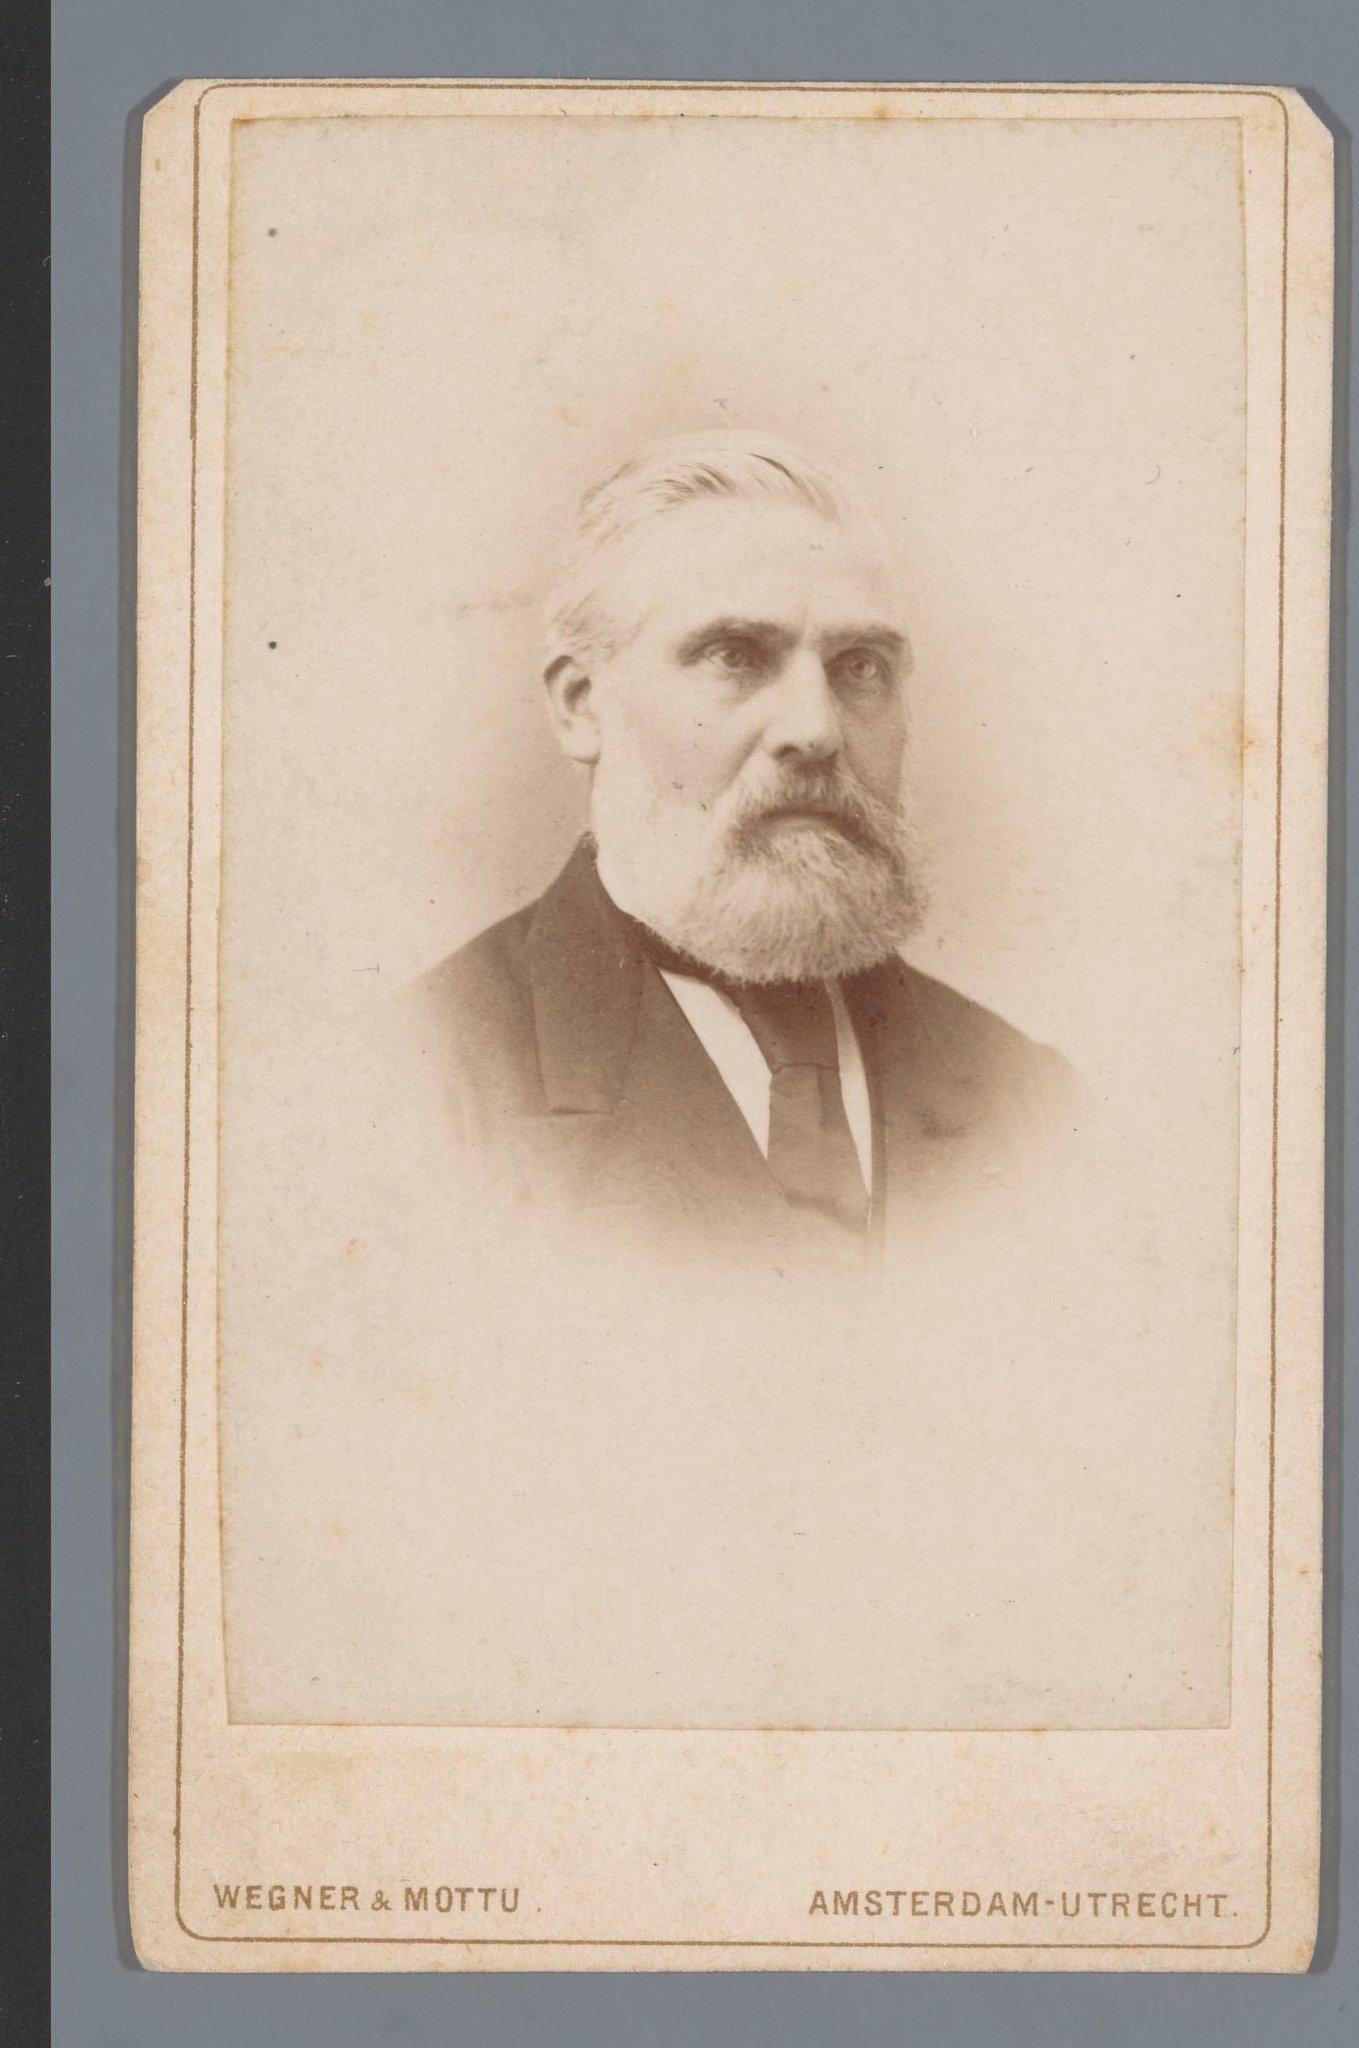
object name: photograph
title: Portret van de heer K. Bouman, onderwijzer, aangeboden aan de heer A.J. Nijland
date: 1812-1879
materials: cardboard, paper, photographic support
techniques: albumen print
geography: amsterdam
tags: historical persons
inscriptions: inscription: ‘Wegner & Mottu Amsterdam-Utrecht’, inscription: ‘Aan den heer A.J. Nijland ter herinnering aan de samenwerking der commissie in zake art 4. enz der Wt lag. onderw. 1878, aangeboden door K. Bouwman dec 1879.’, signature: ‘Photographische artistisch atelier Wegner & Mottu Amsterdam Utrecht. Het cliche wordt voor verdere bestellingen bewaard.’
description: Carte-de-visite is onderdeel van een groep portretten aangeboden aan A.J. Nijland, verzamelaar van historieprenten, december 1879